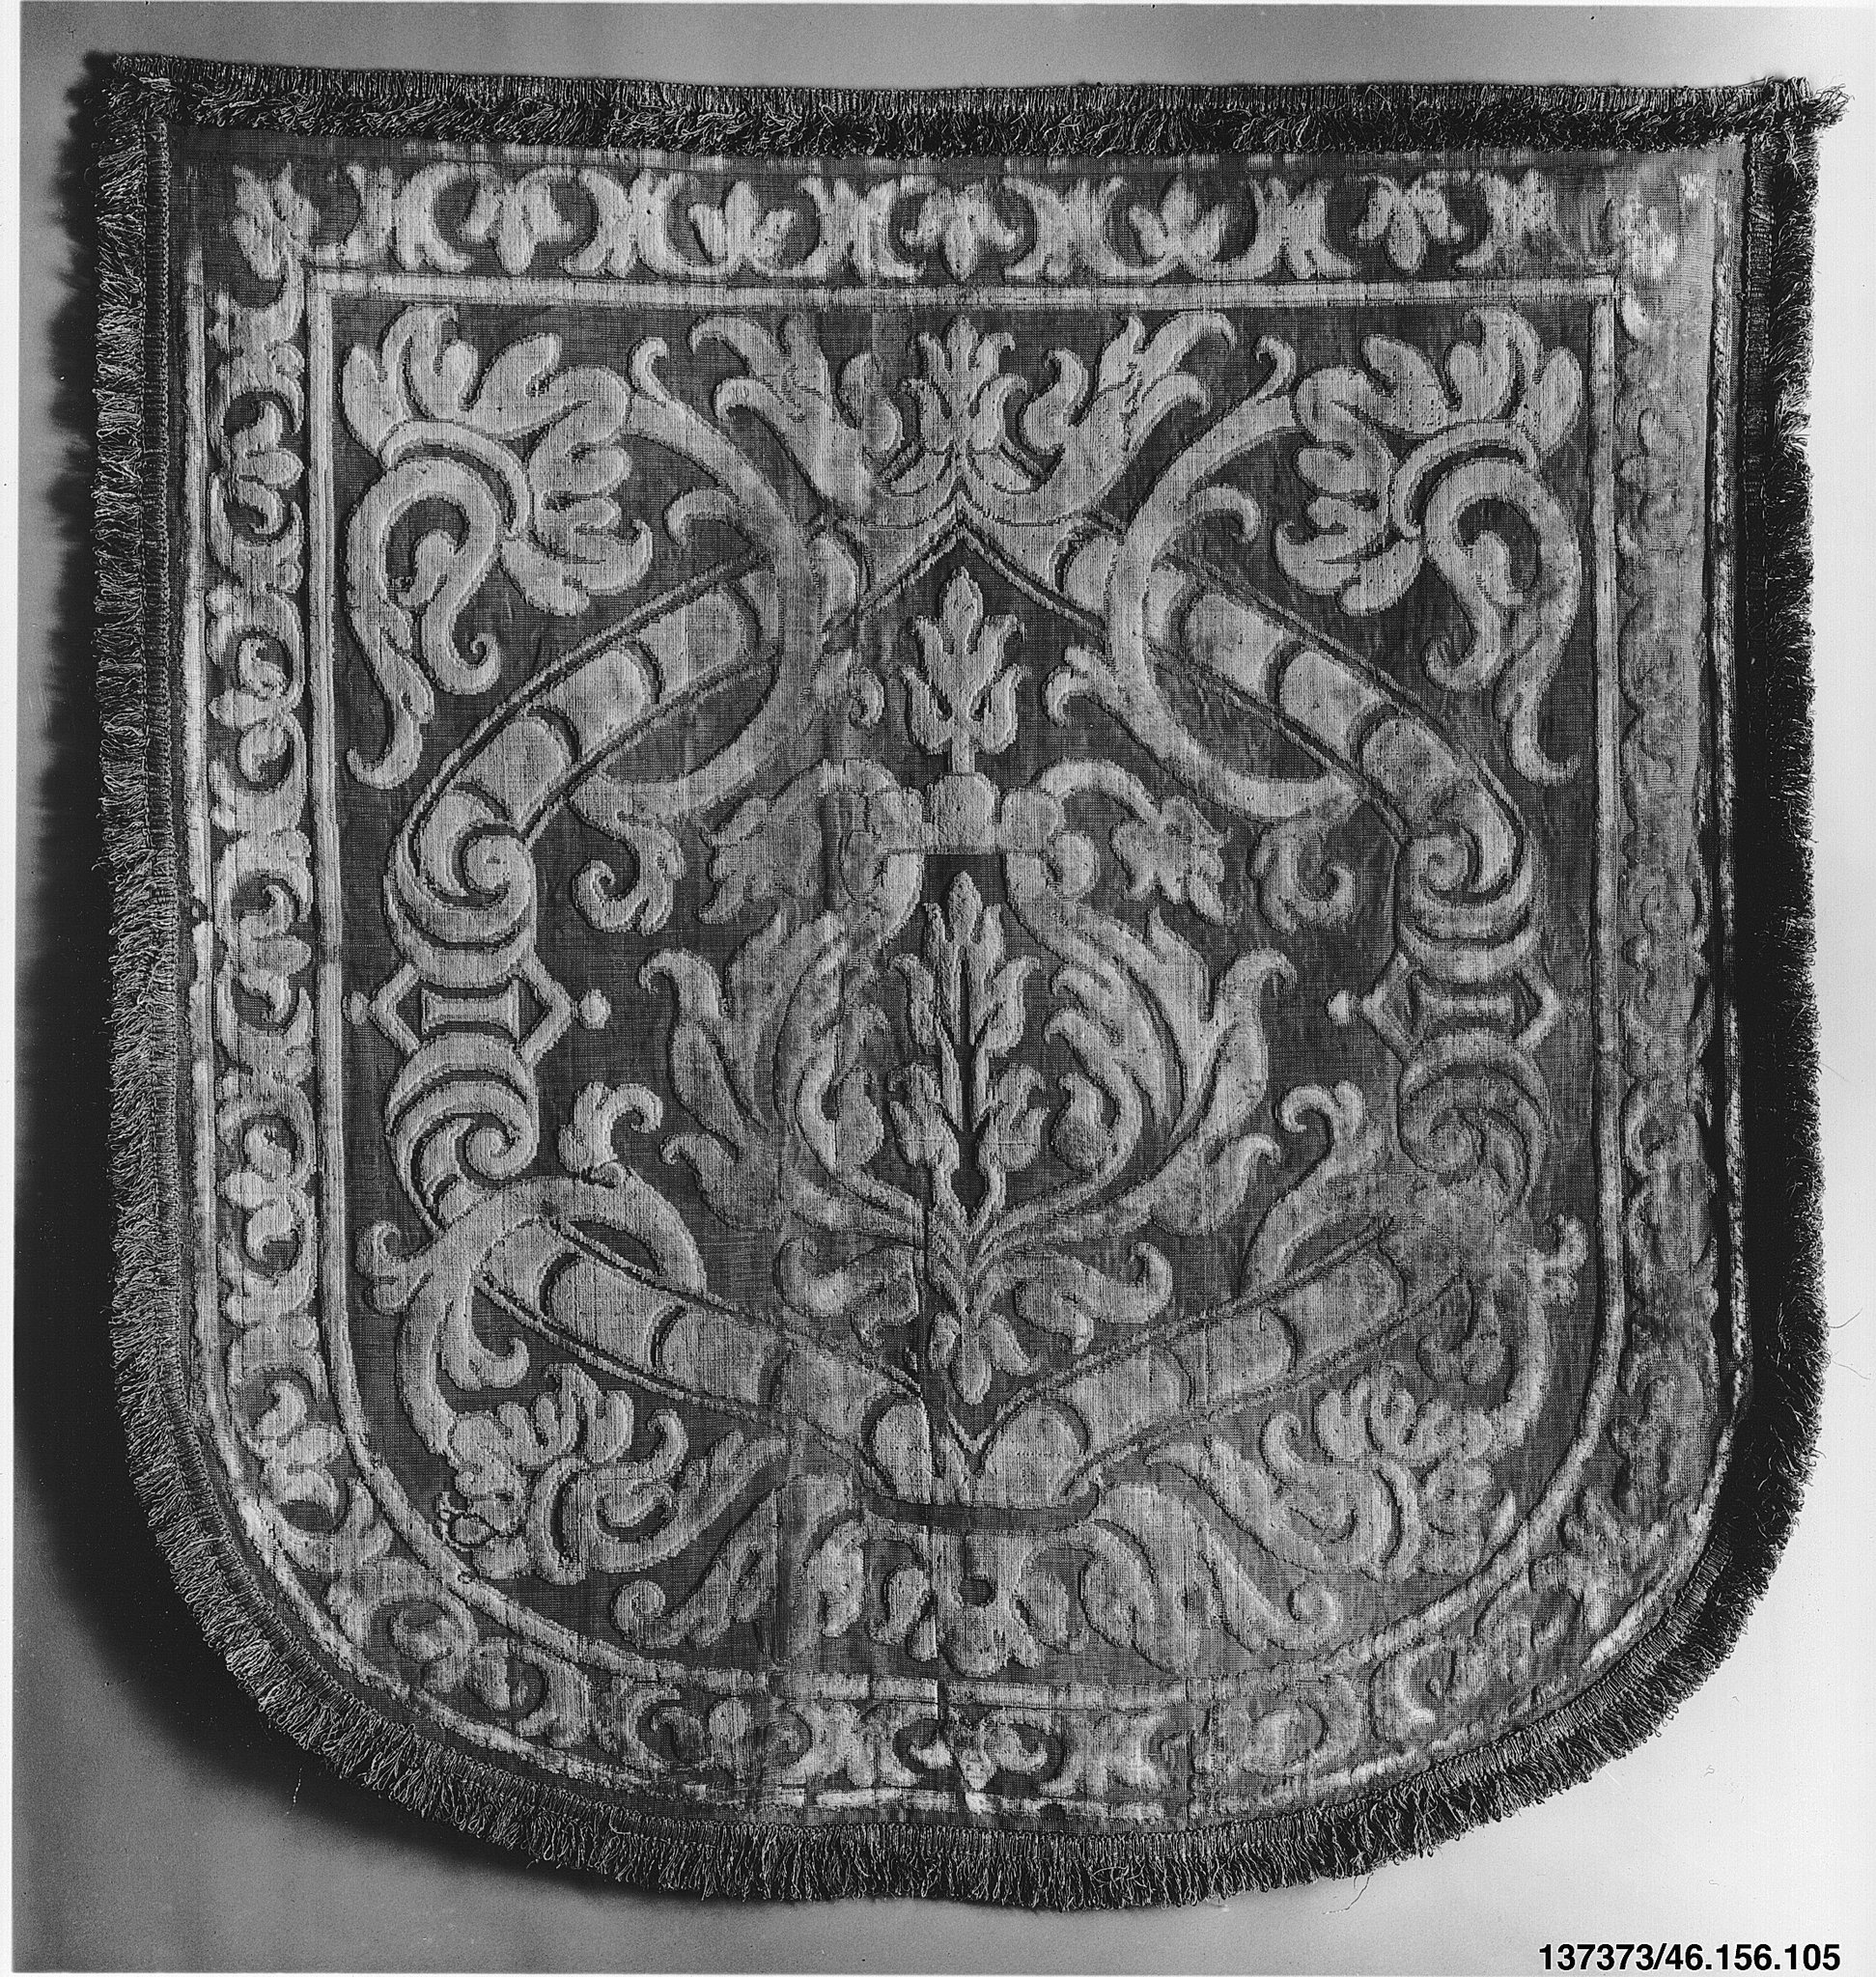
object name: hood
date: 1567-1600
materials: metal thread, silk